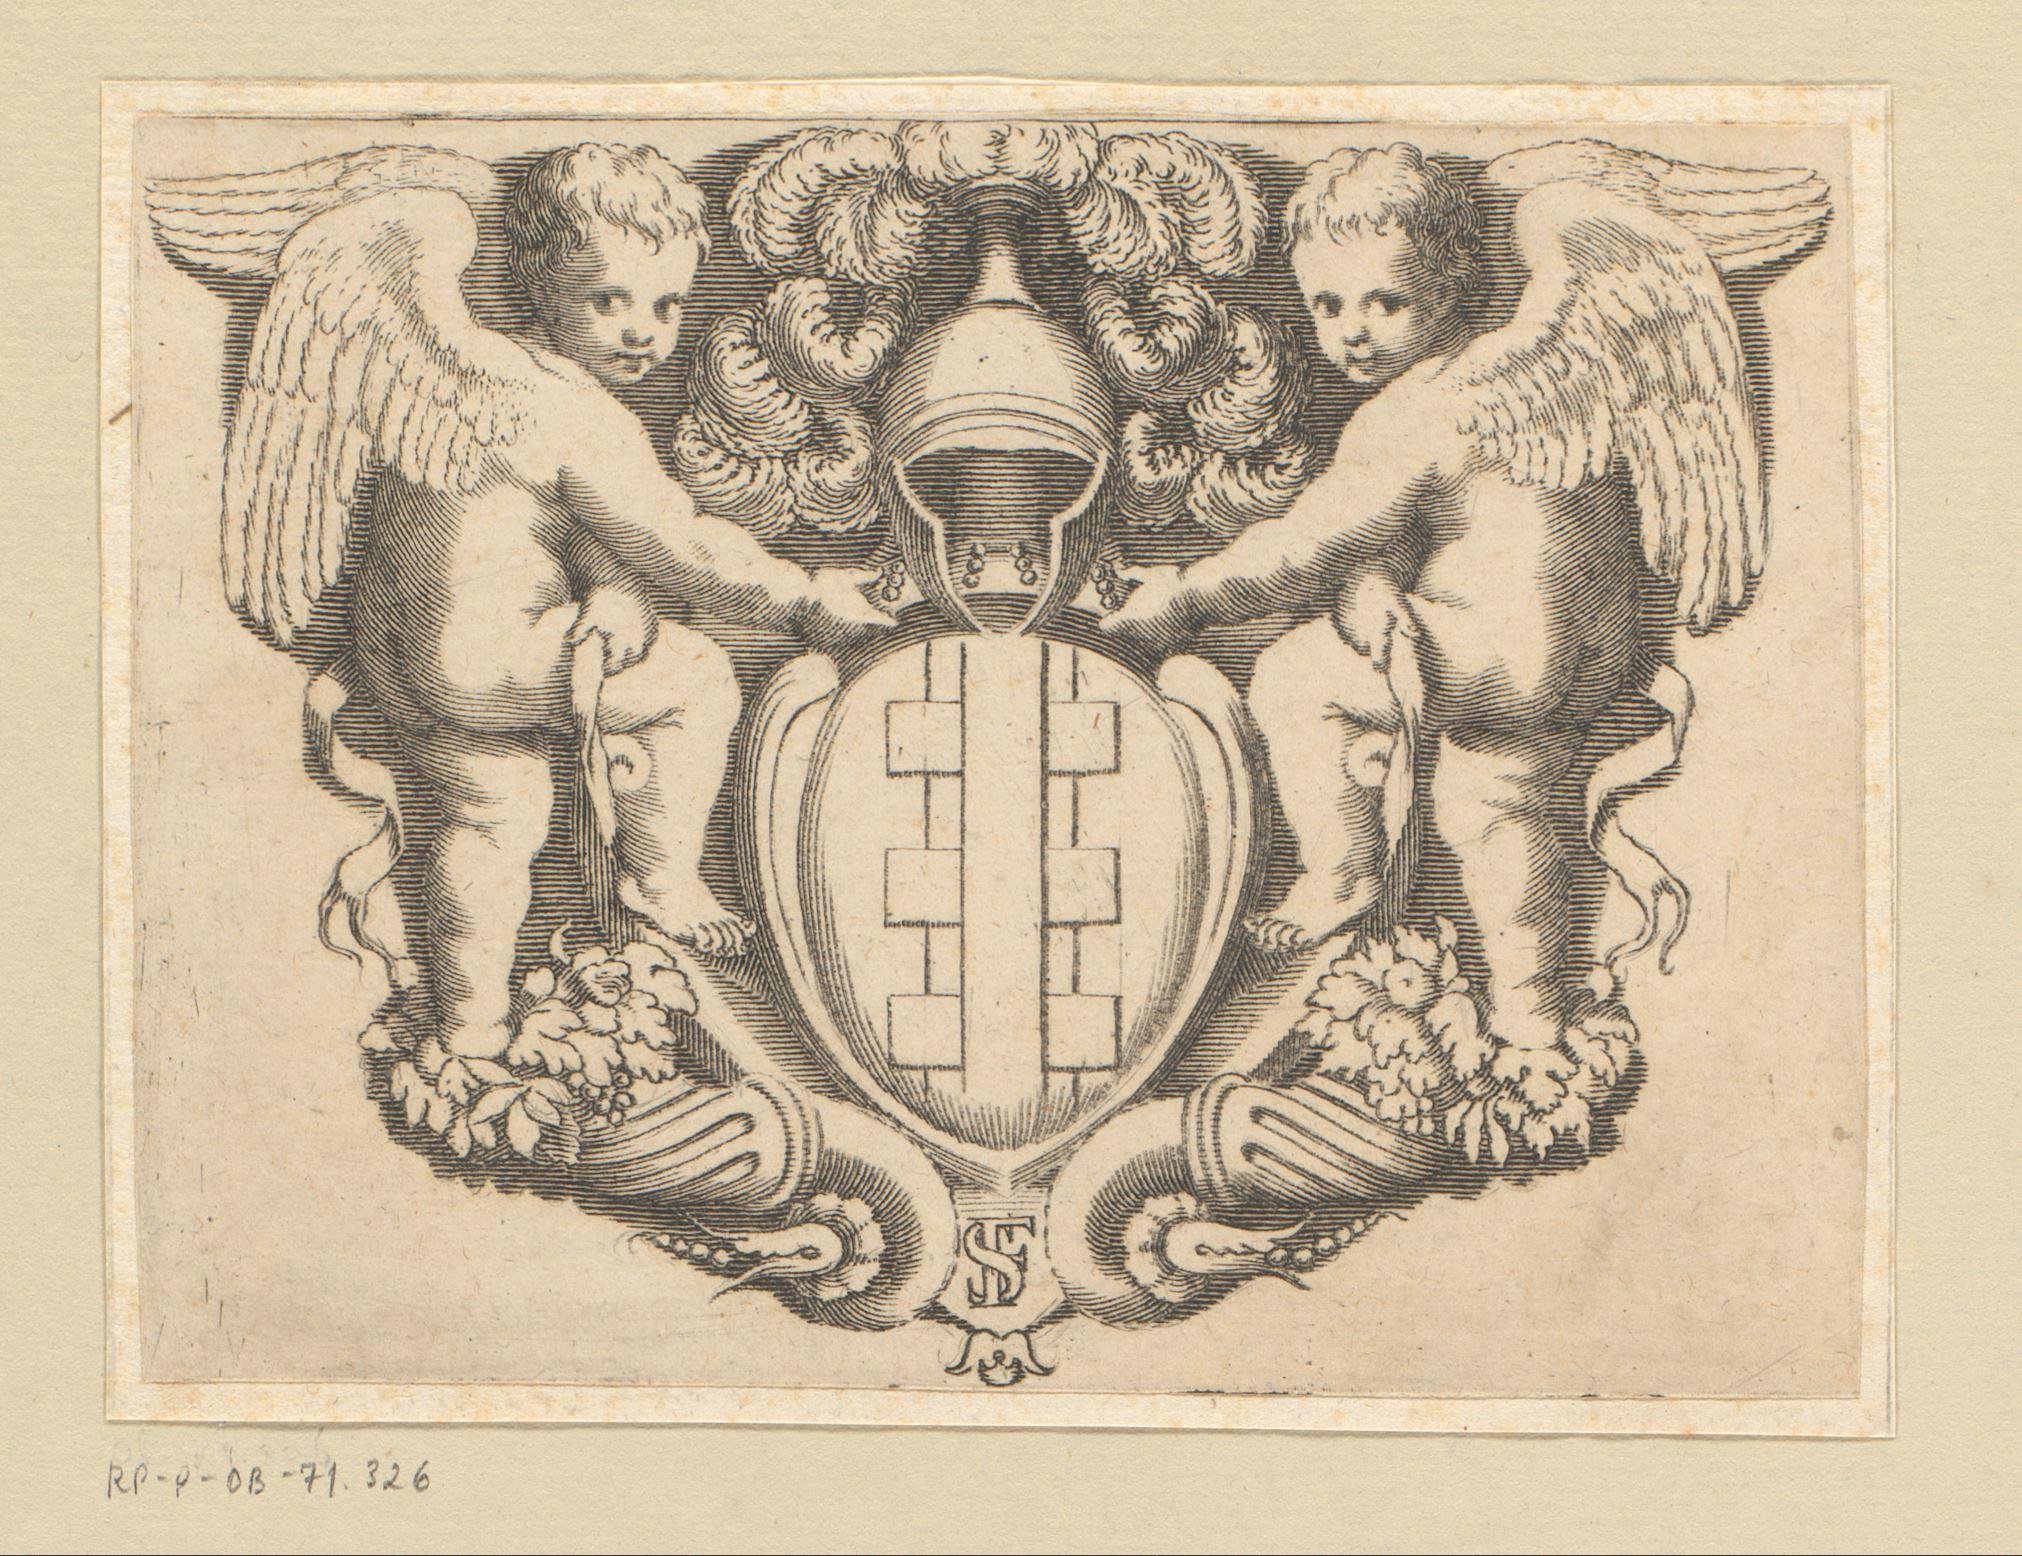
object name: print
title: Twee putti bij een wapenschild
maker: claude mellan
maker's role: draughtsman, print maker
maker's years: 1598-1688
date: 1608-1688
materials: paper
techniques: engraving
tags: cupids: 'amores', 'amoretti', 'putti', armorial bearing, heraldry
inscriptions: collector's mark: Lugt 240